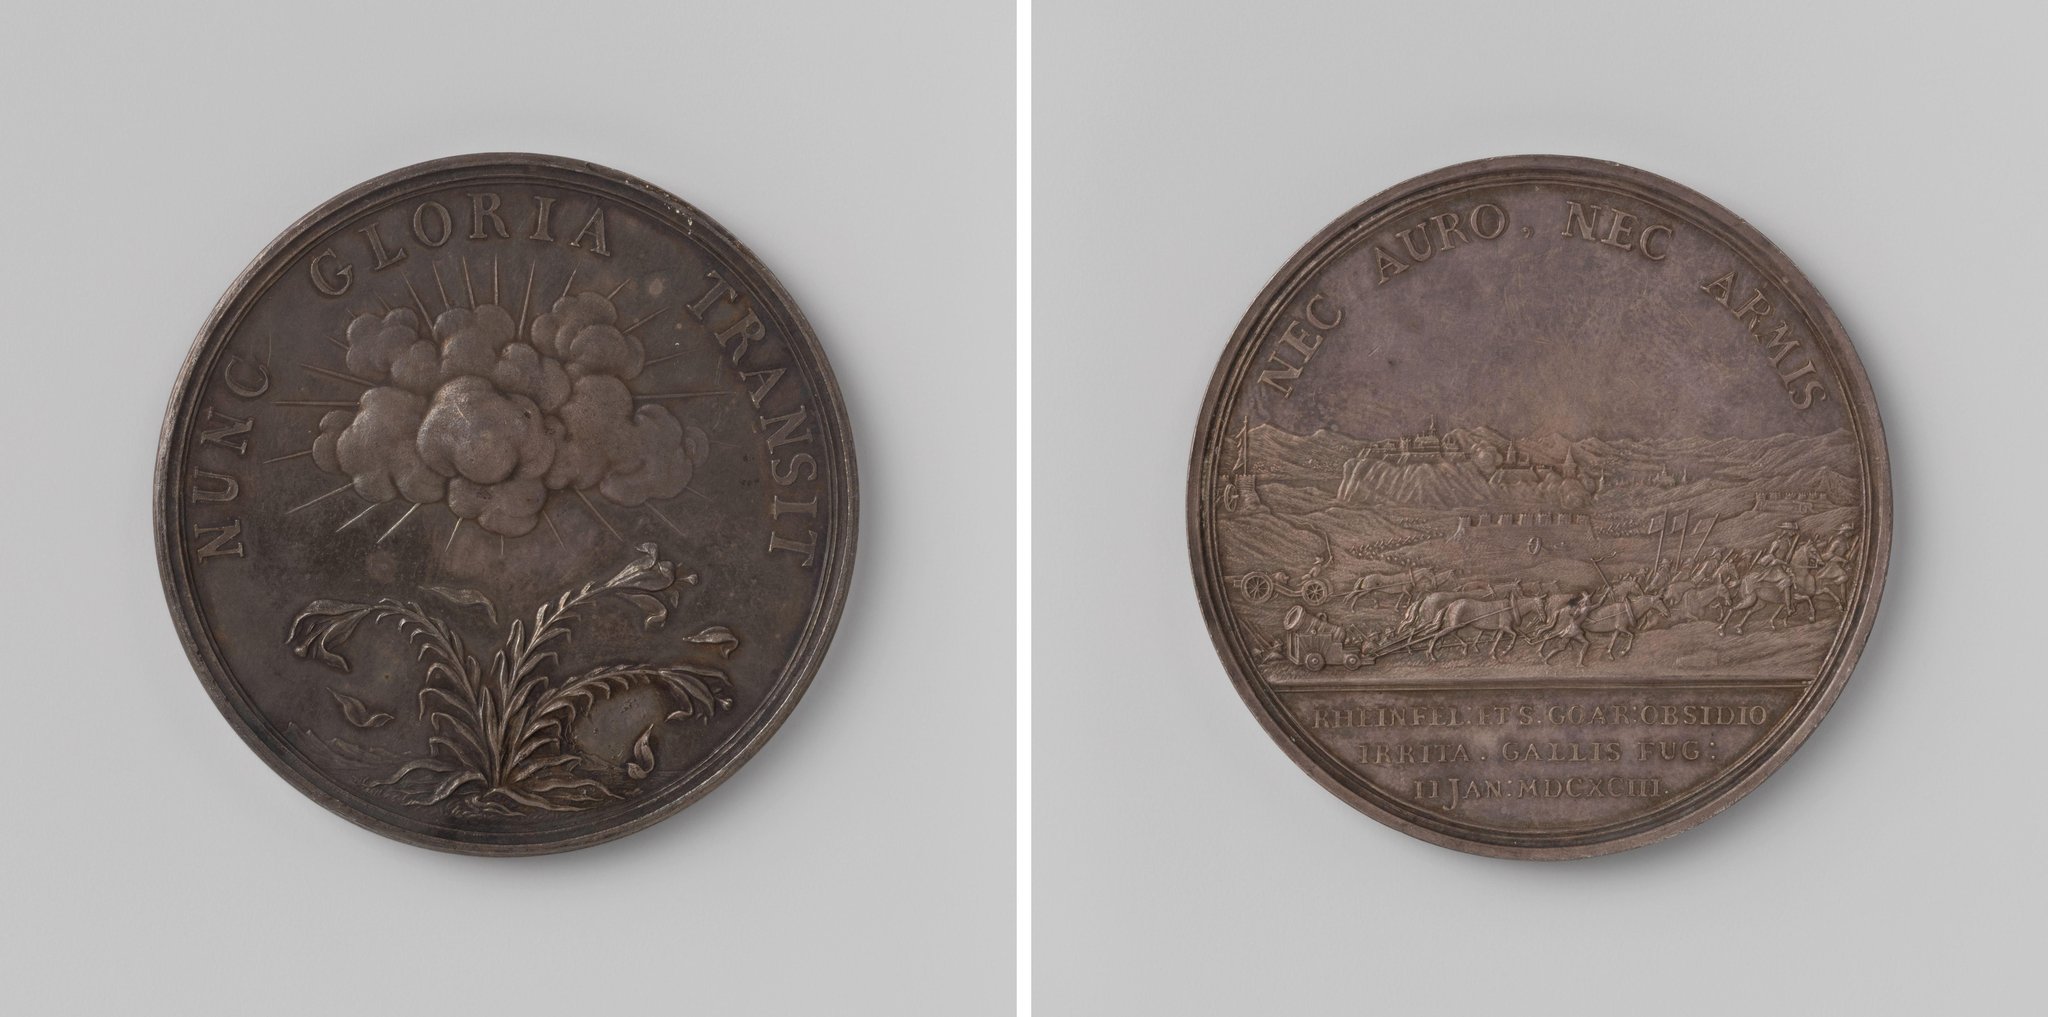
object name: history medal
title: Rheinfels en St. Goar ontzet door de Landgraaf van Hessen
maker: jan smeltzing (i)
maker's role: modelleur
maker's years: 1656-1693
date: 1693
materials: silver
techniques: striking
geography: leiden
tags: frederik i (koning van zweden)